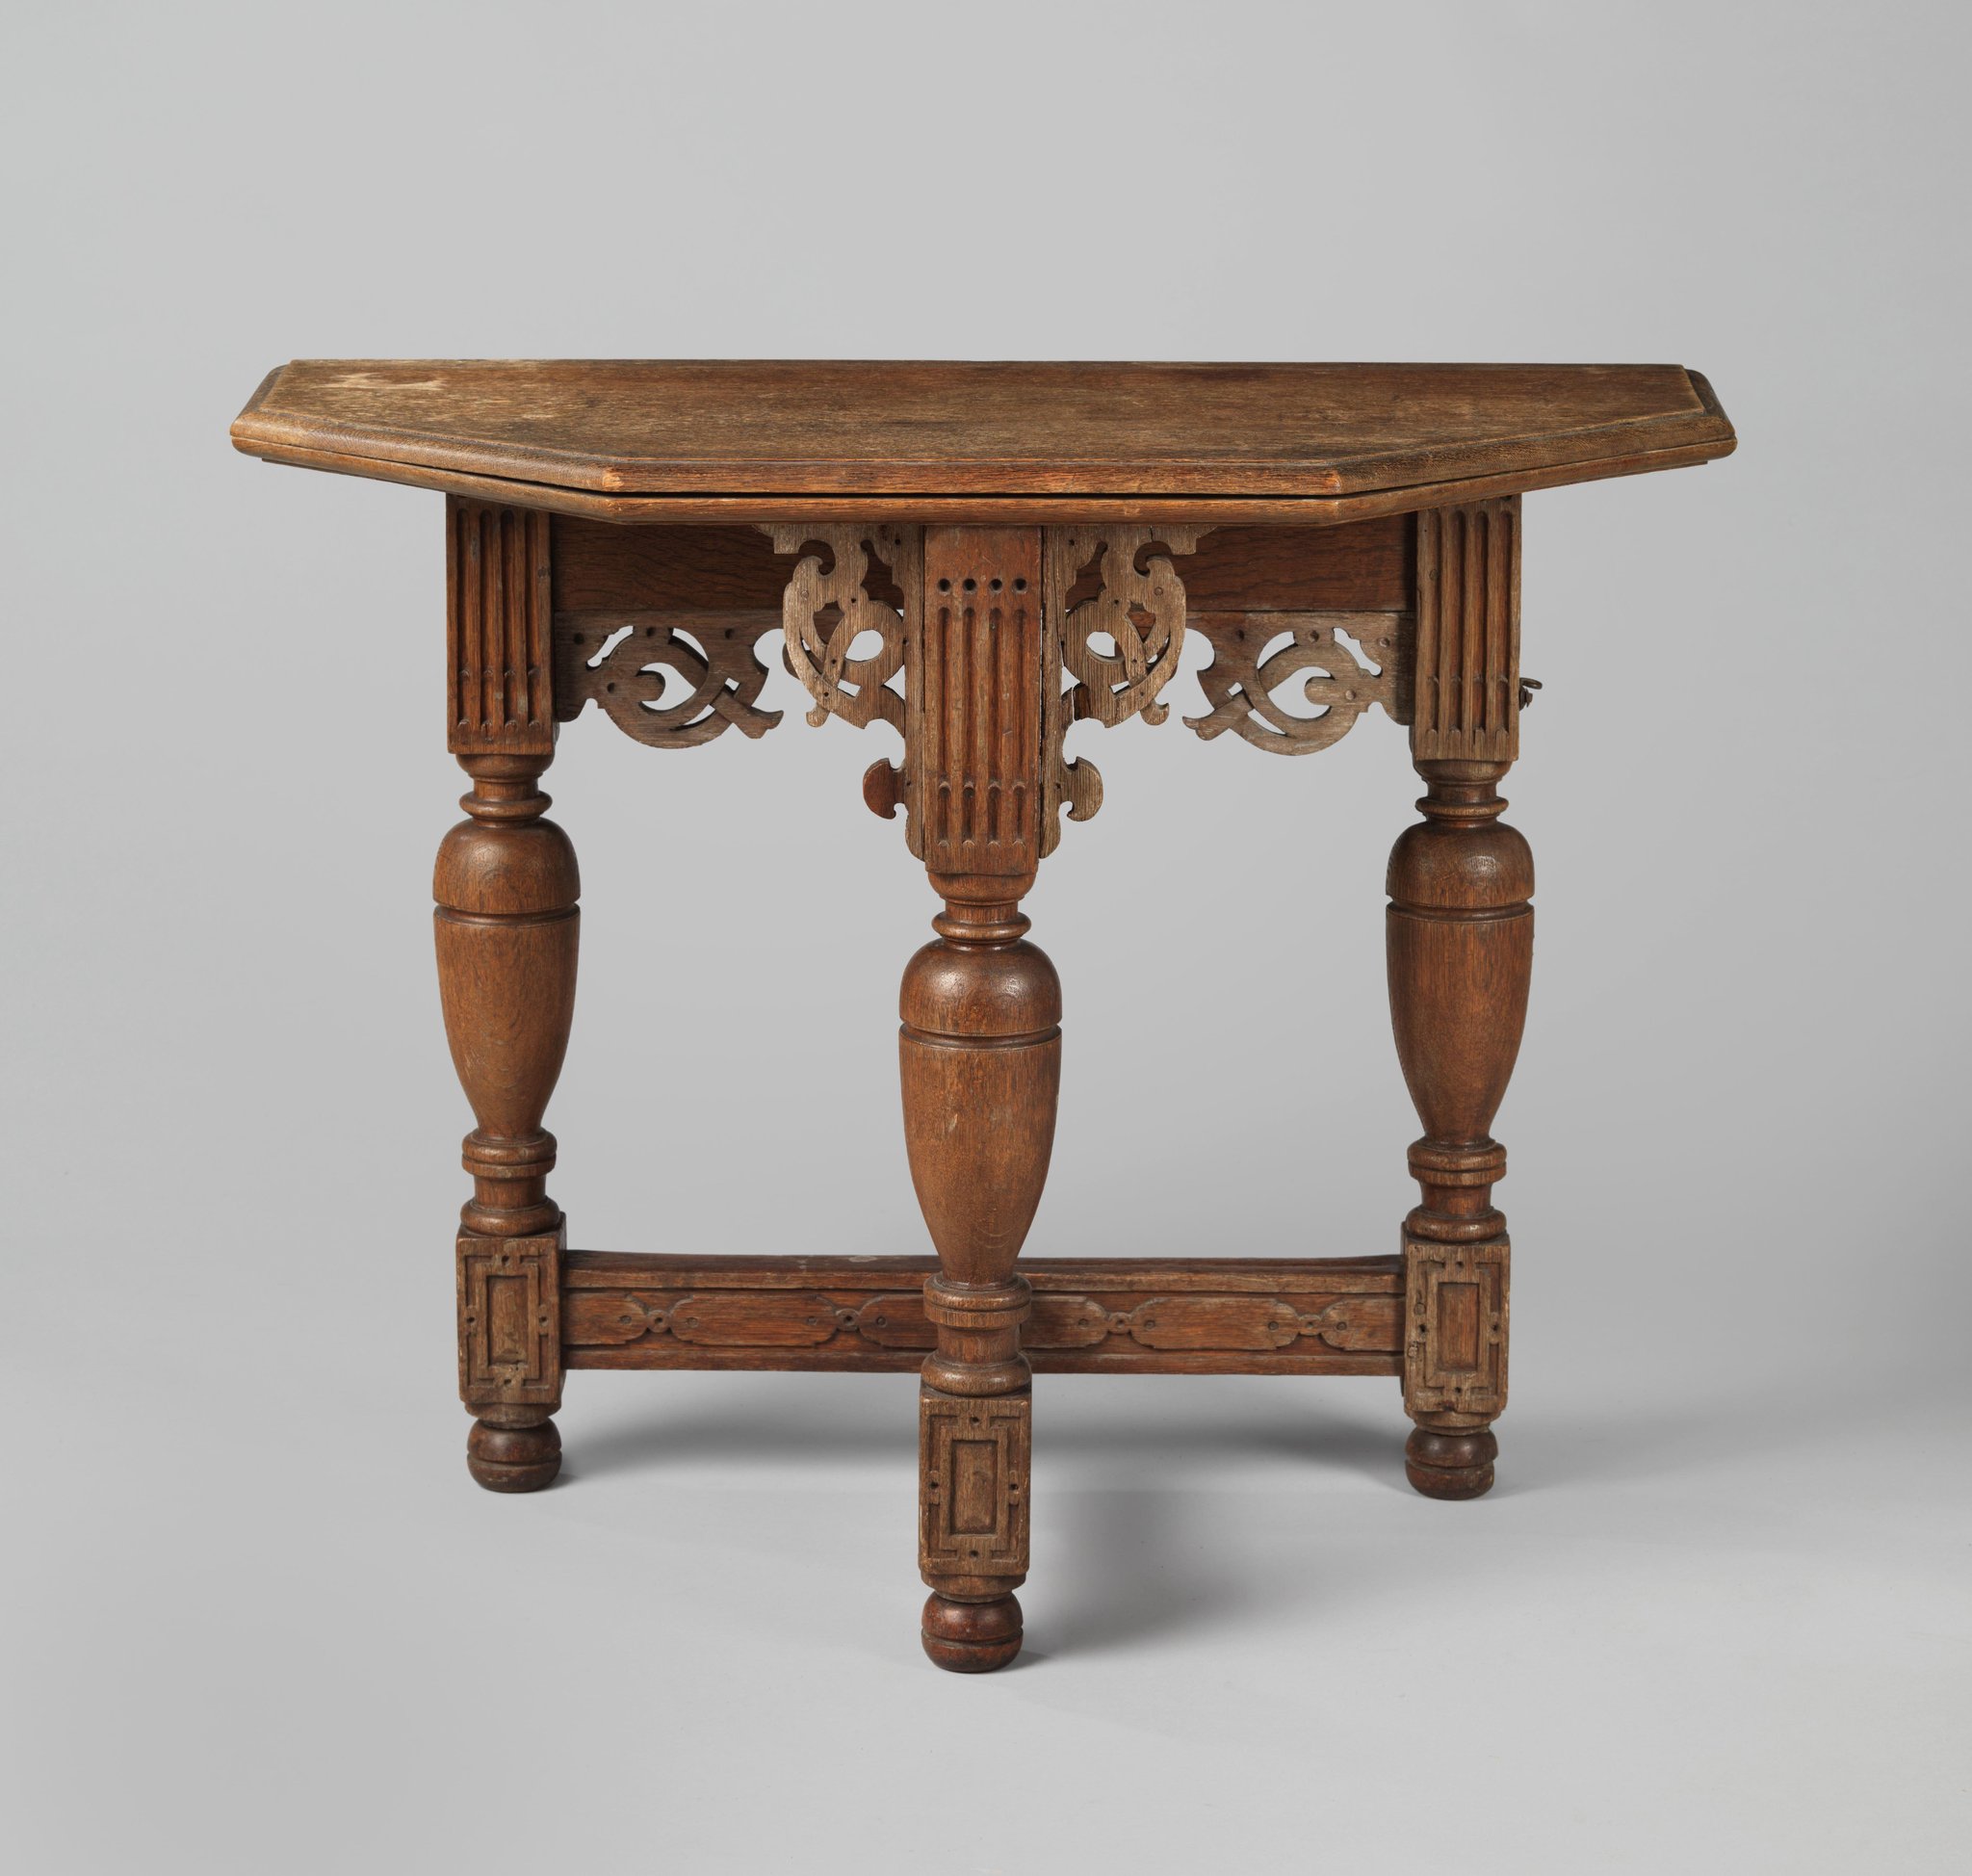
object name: table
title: Driepootstafel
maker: Anonymous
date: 1600-1650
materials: wood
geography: netherlands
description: Driepootstafel van eikenhout met een achthoekig samenvouwbaar blad, op drie slanke vaaspoten door een T-vormig kruis verbonden. De poten hebben huizen, die boven gecanneleerd, onder, evenals de regels, met vlak kettingornament versierd zijn. Een der zijpoten is verticaal doorgezaagd en draaibaar als steun voor het uitklapblad. De steunstukken zijn opengewerkt.